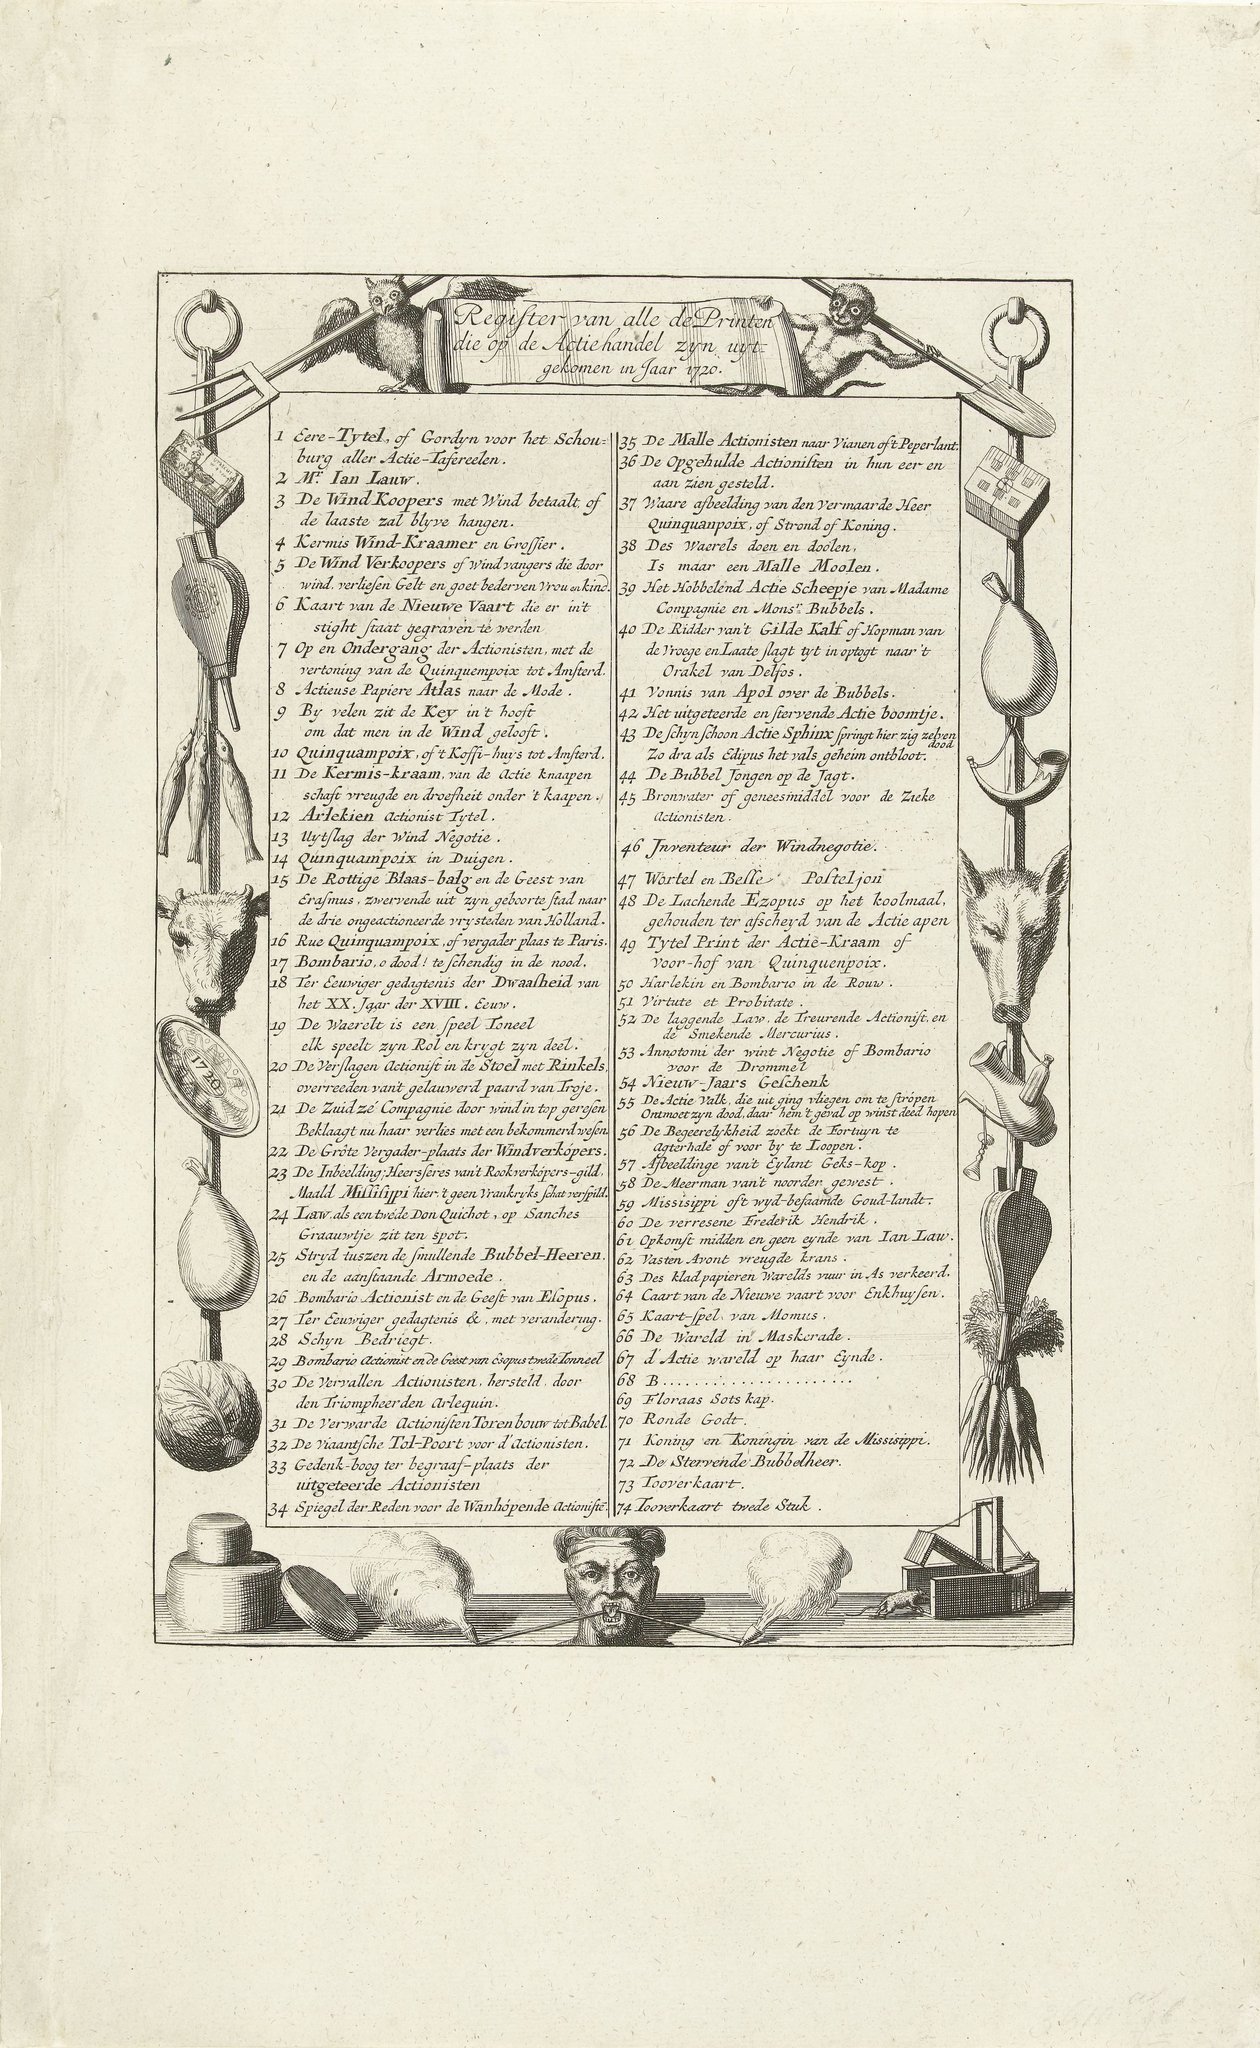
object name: print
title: Het Groote Tafereel der Dwaasheid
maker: Anonymous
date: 1720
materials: paper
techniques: etching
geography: northern netherlands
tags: windhandel van 1720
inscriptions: collector's mark: Lugt 2228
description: Register van de prenten in Het Groote Tafereel der Dwaasheid. Lijst van prenten genummerd 1-74 (de nummering waarop Muller de zijne heeft gebaseerd). In een omlijsting versierd met dierenkoppen, groenten, een roker met twee pijpen en allerlei voorwerpen. Register op de serie Tafereel der Dwaasheid met spotprenten op de Windhandel of Actiehandel van 1720.